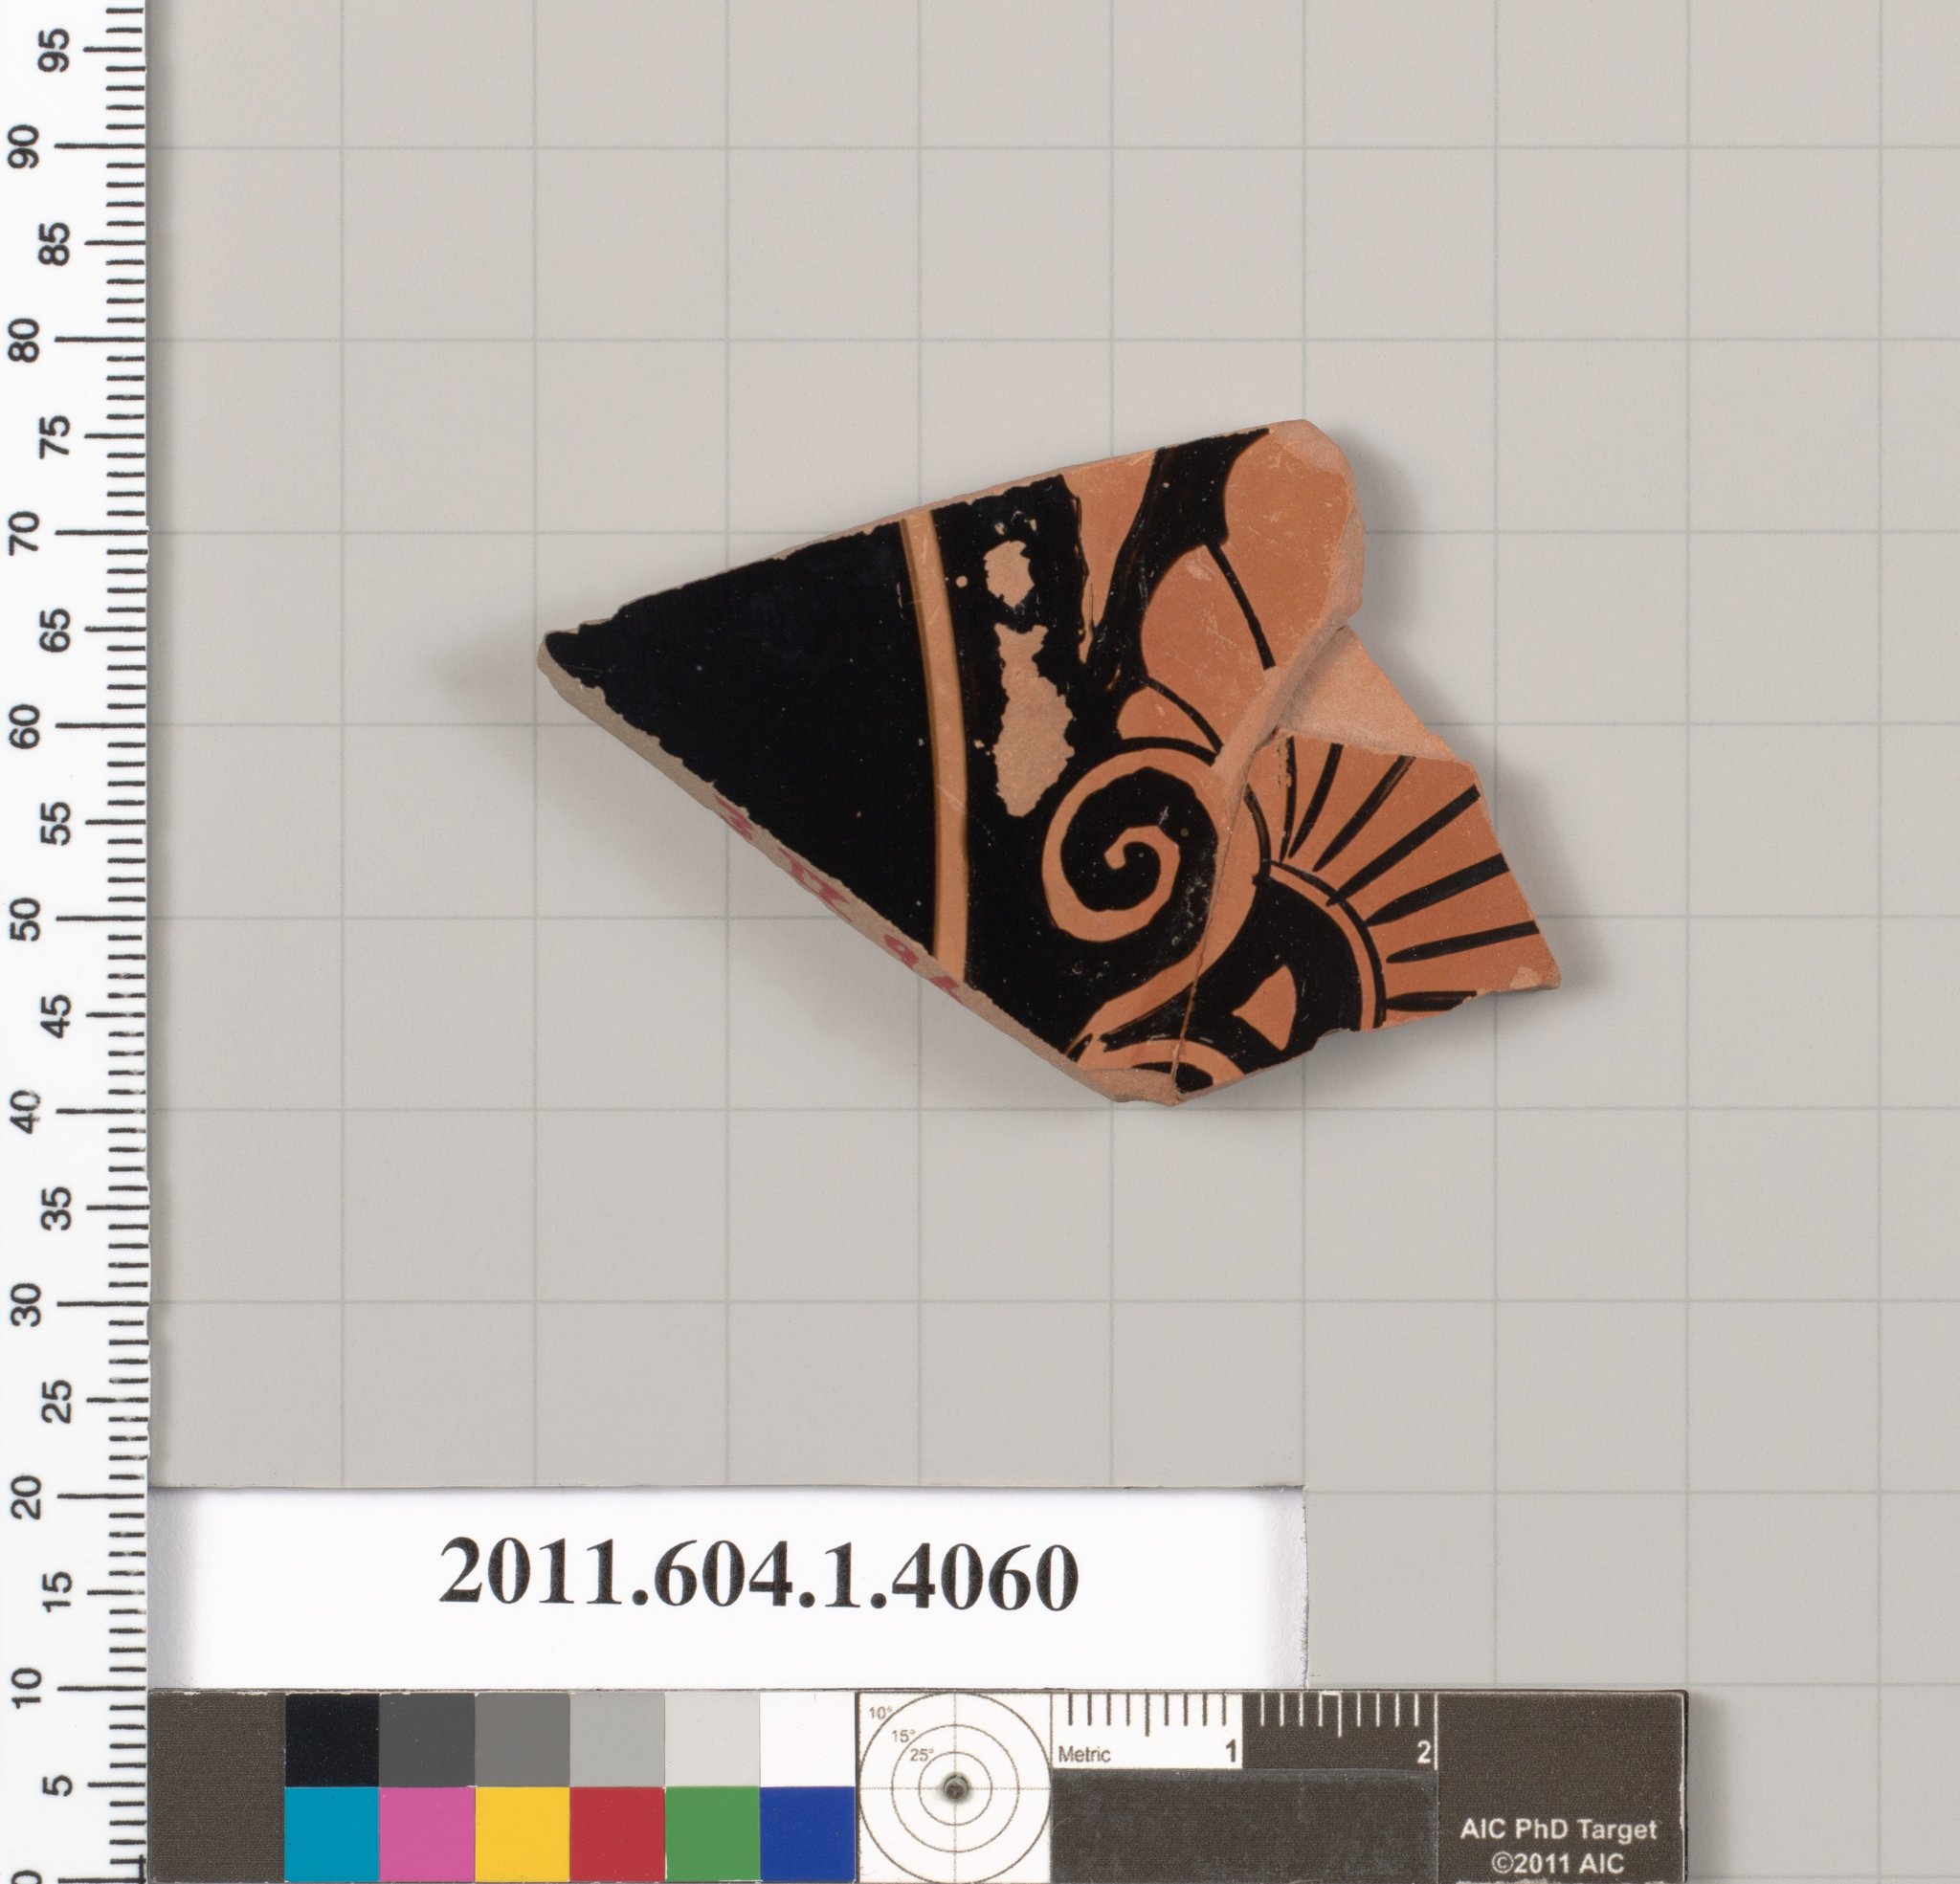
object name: kylix fragment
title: Terracotta fragment of a kylix (drinking cup)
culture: greek, attic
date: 500-476 BCE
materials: terracotta